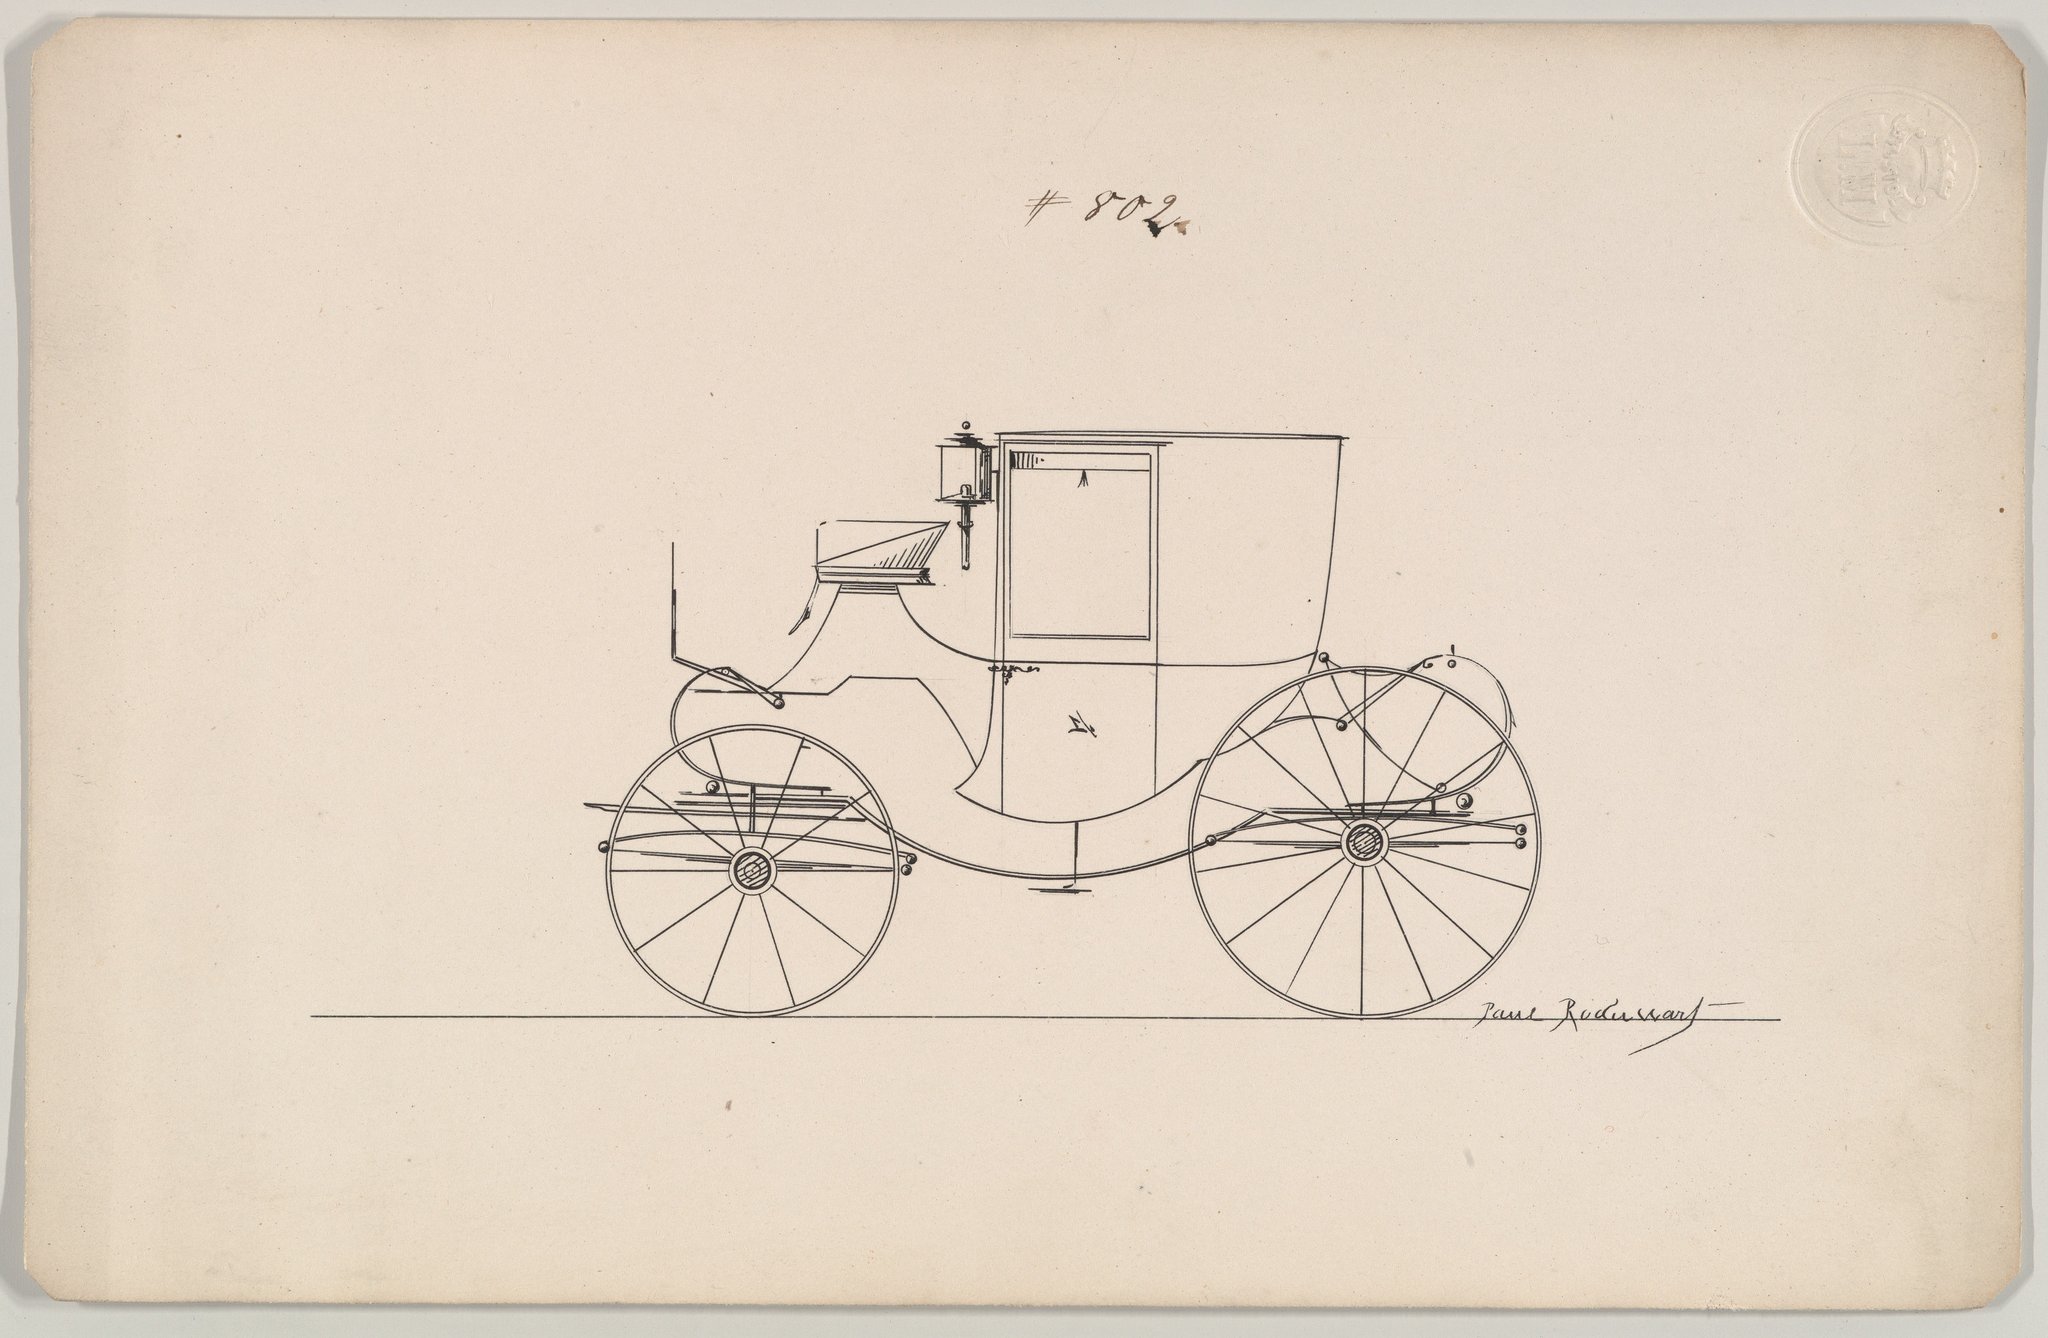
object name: drawing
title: Coupe #802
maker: brewster & co.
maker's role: manufacturer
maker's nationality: american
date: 1860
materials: ink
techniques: pen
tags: carriages